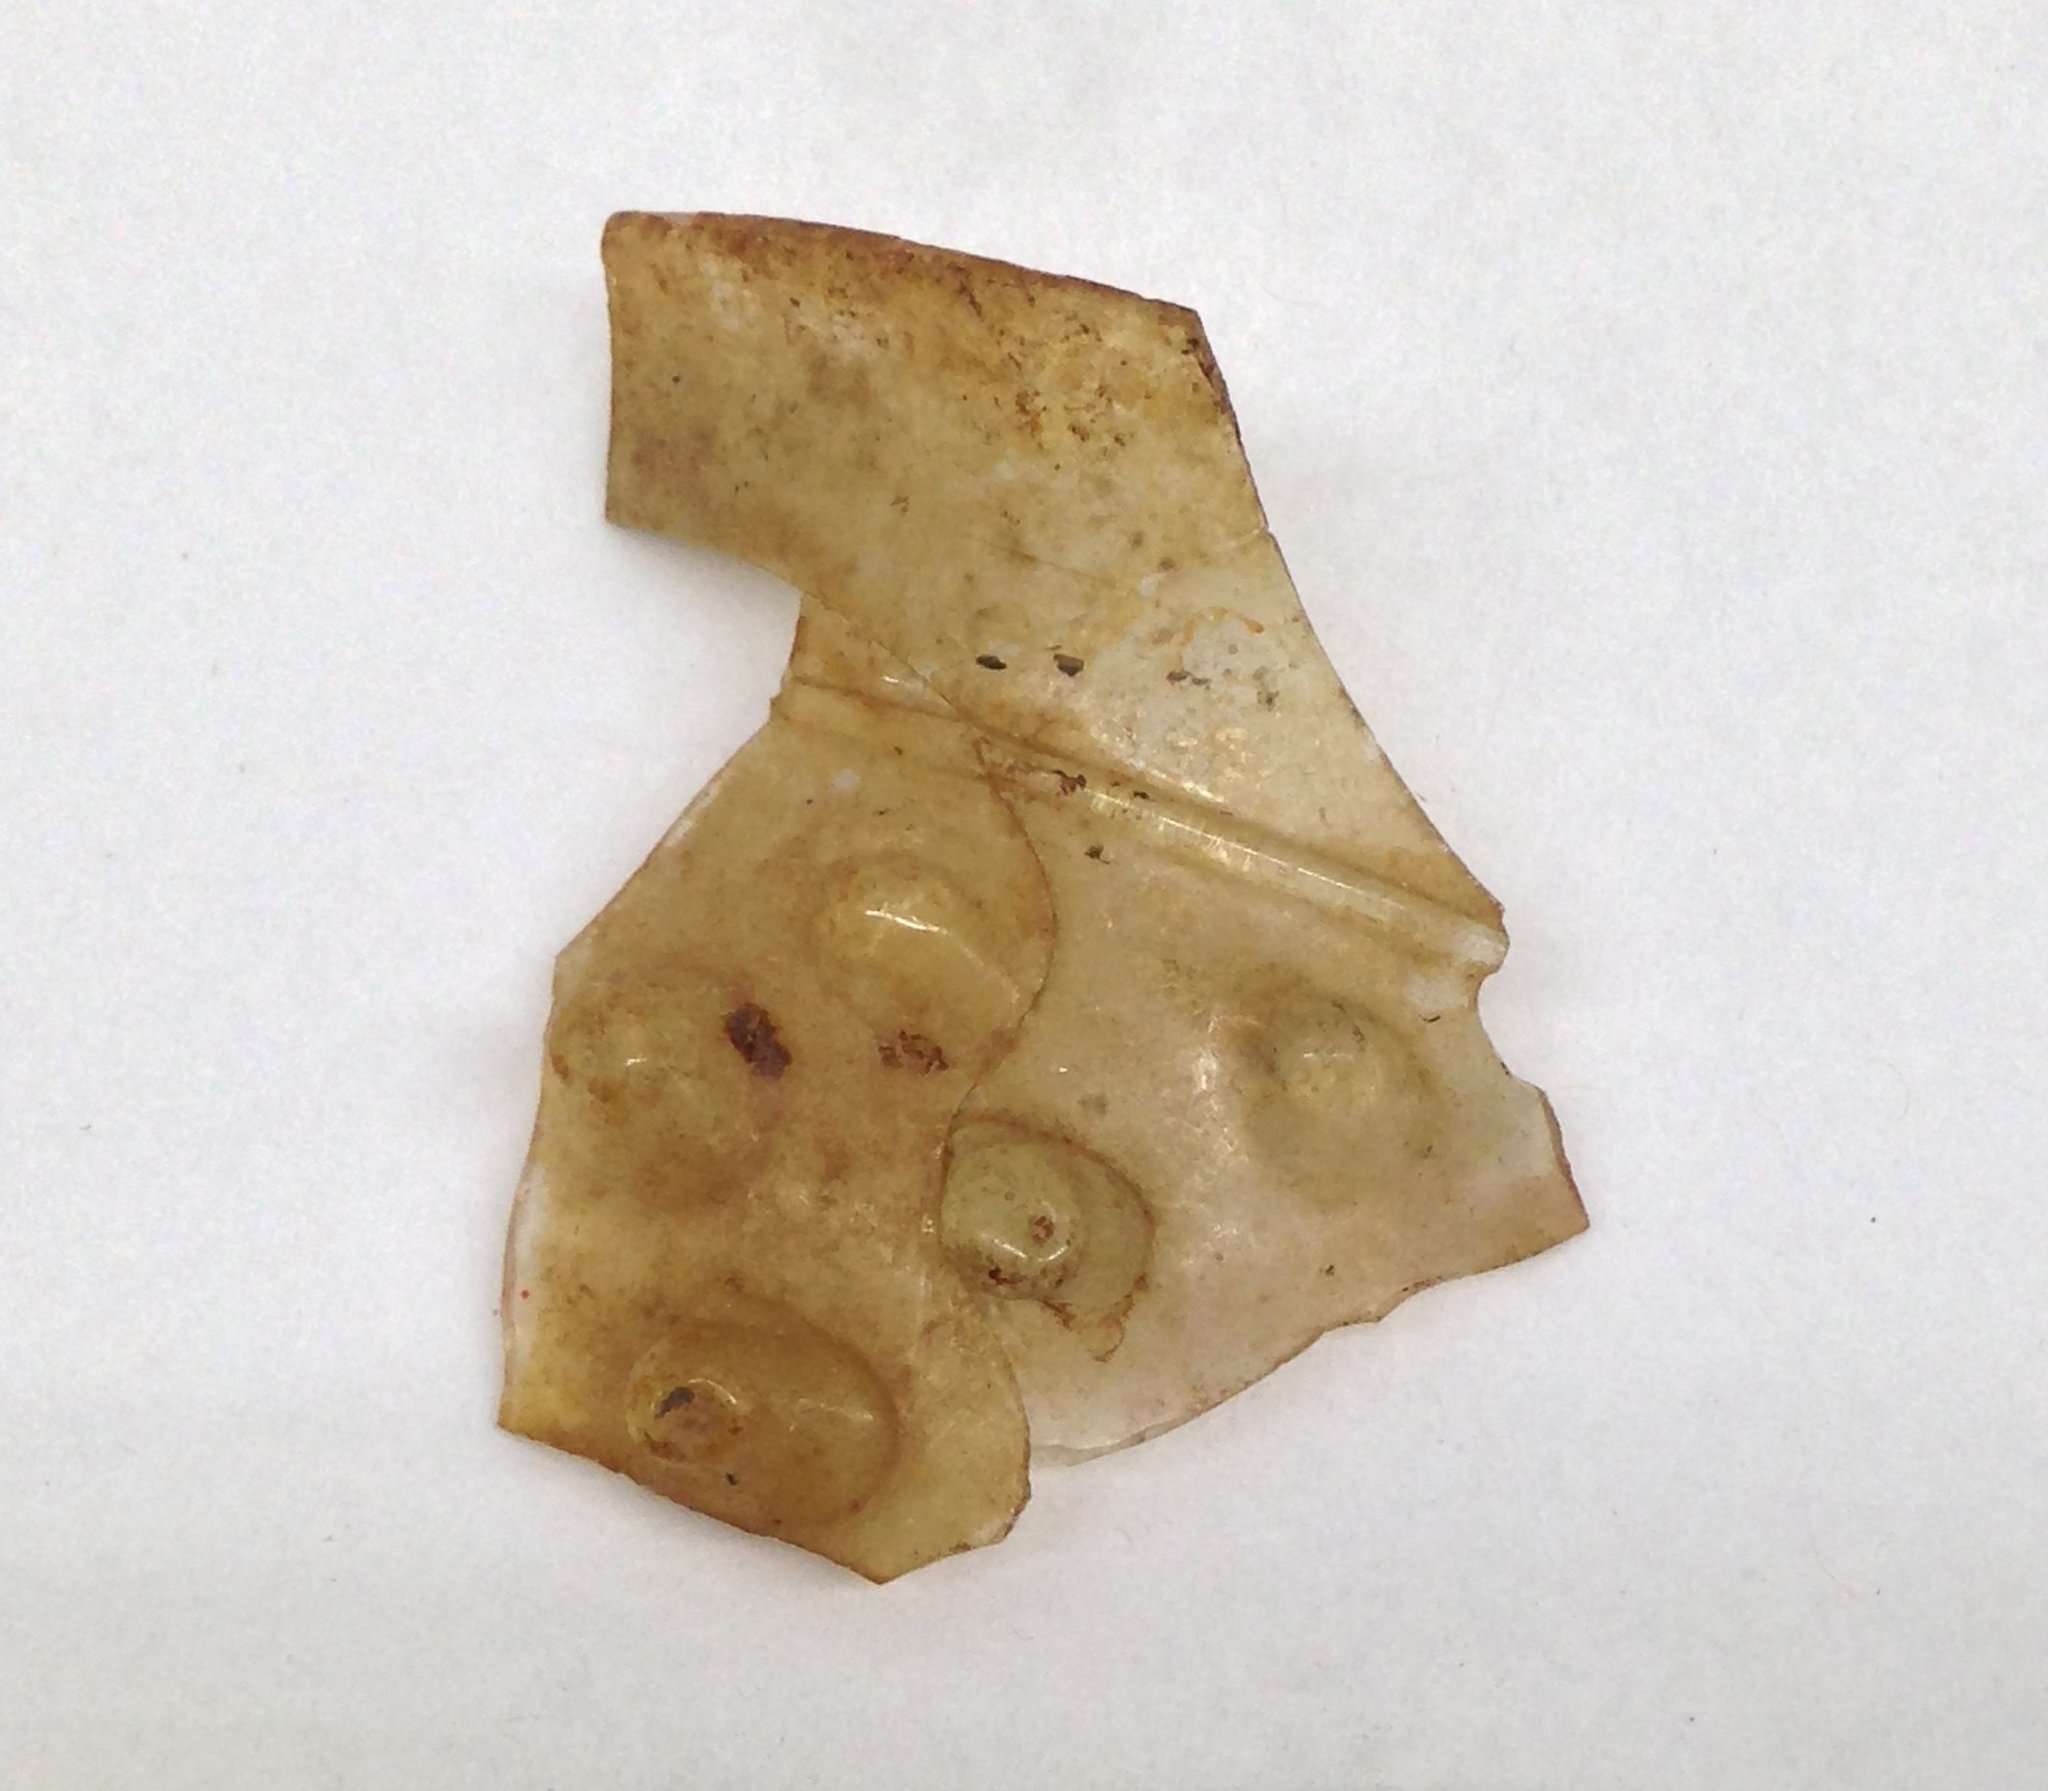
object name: fragment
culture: european or middle eastern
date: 1150-1250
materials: ceramic, glass